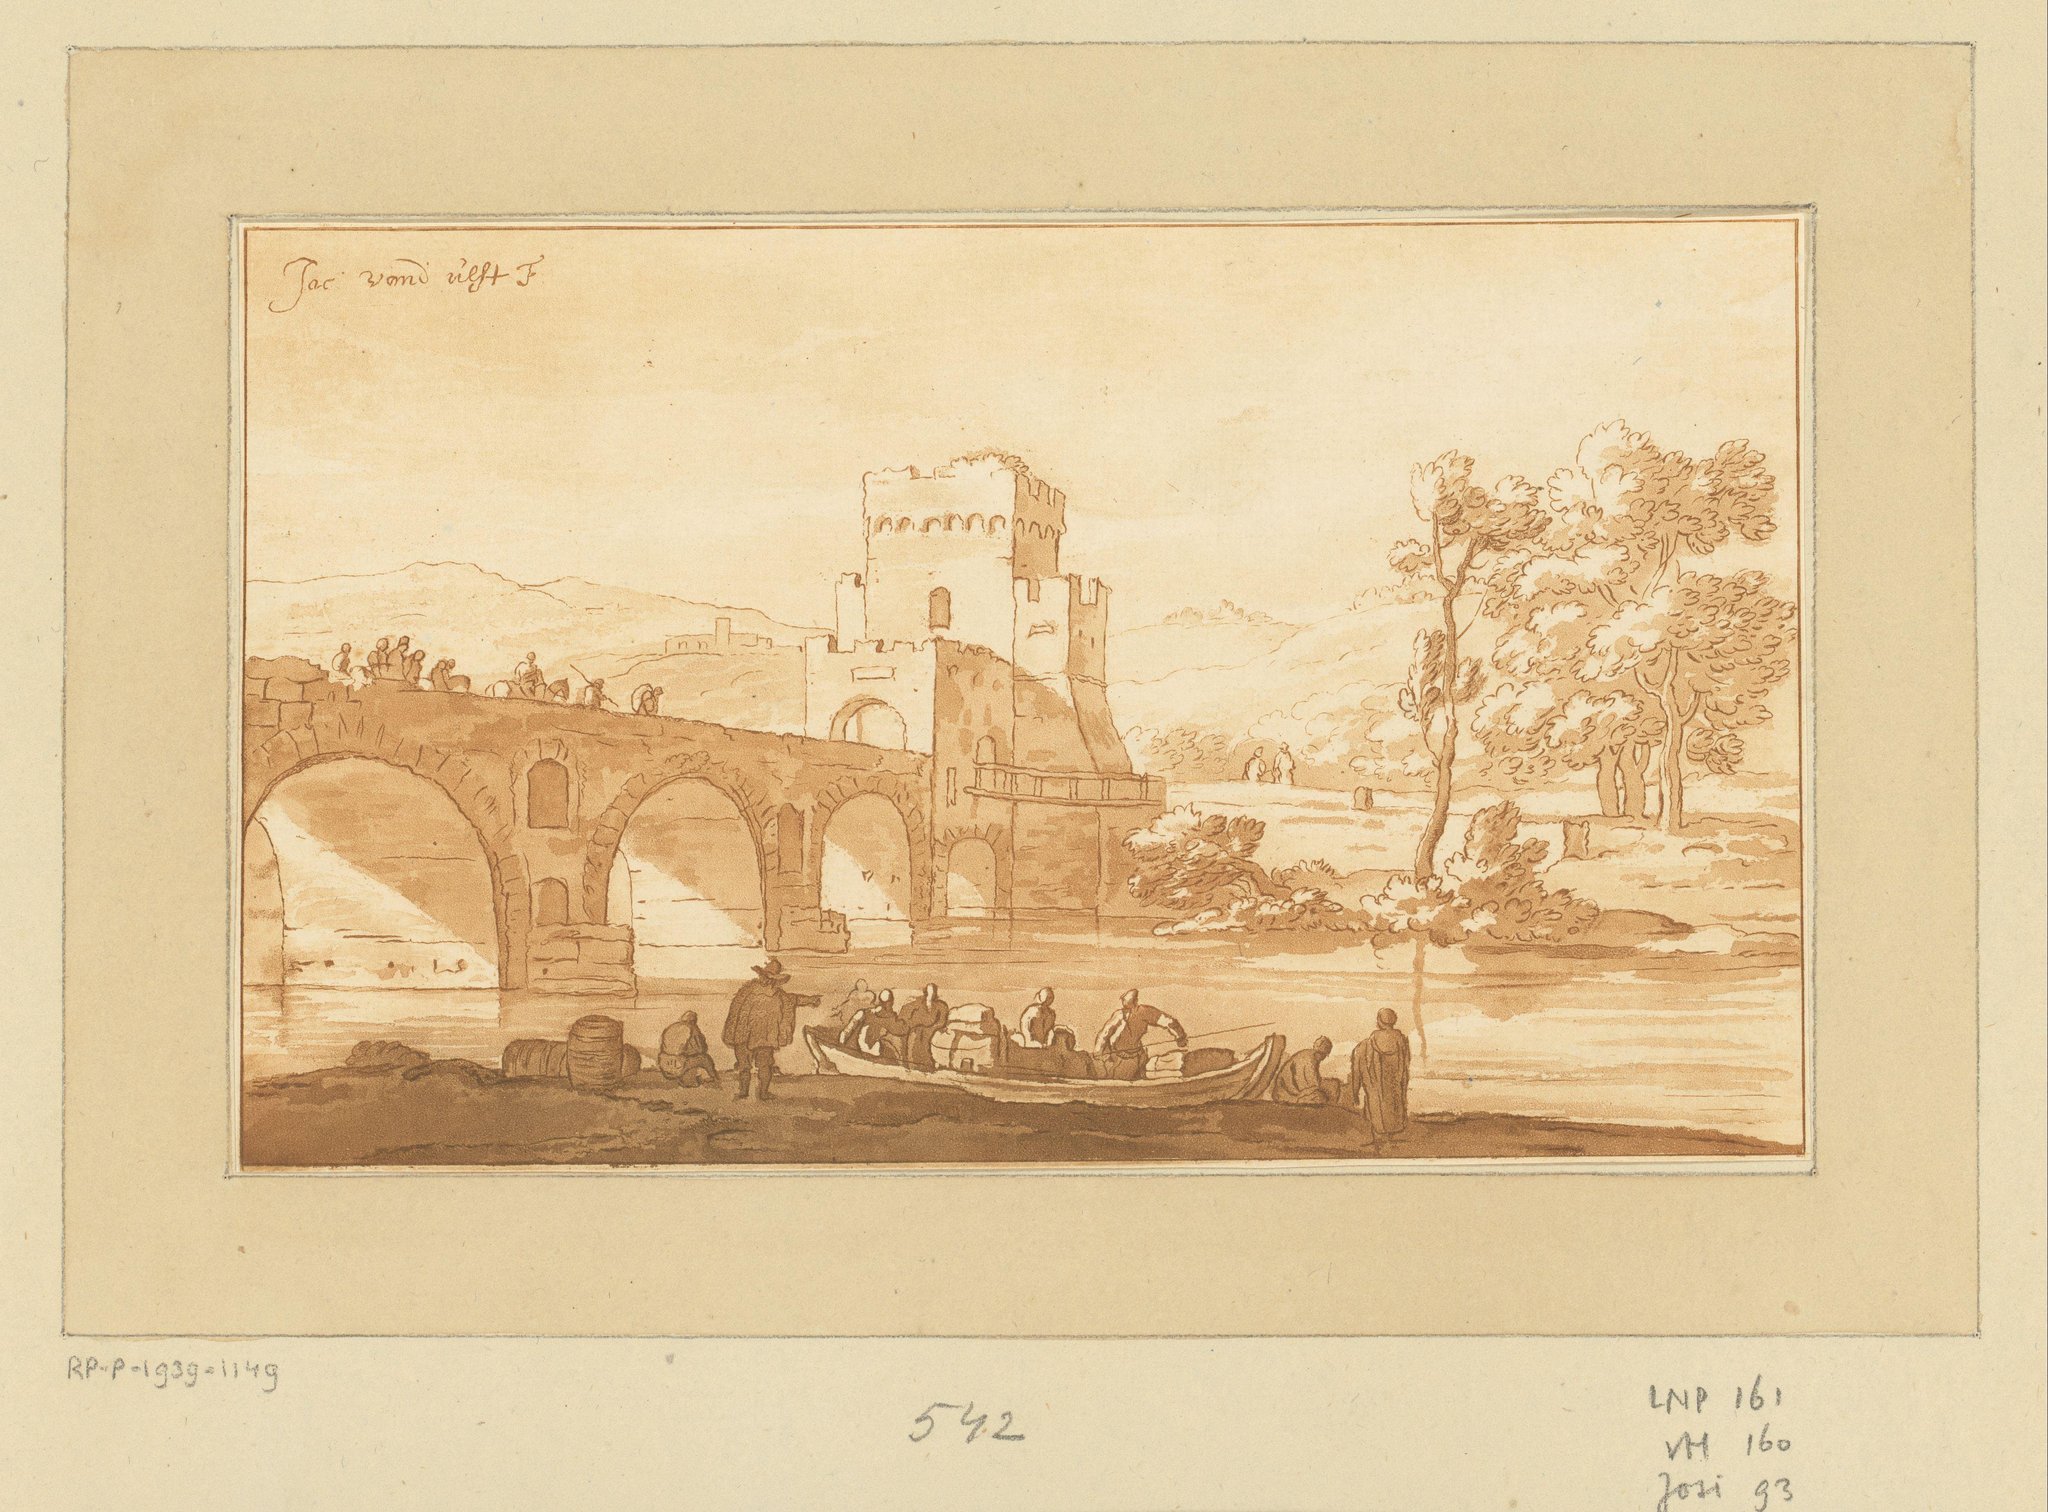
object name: print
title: Ponte Molle bij Rome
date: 1741-1803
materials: paper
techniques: etching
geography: amsterdam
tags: landscape with bridge, viaduct or aqueduct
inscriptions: collector's mark: ‘RIJKS / MUSM’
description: Cornelis Brouwer heeft in samenwerking met C.S. Roos een aantal prenttekeningen uitgegeven welke op het verso het signatuur C.Brouwer fecit en C.S. Roos excudit Amst. dragen. De prent werd opgenomen in: Collection d'imitations de dessins d'après les principaux maîtres hollandais et flamands, Londen, C. Josi, 1821.